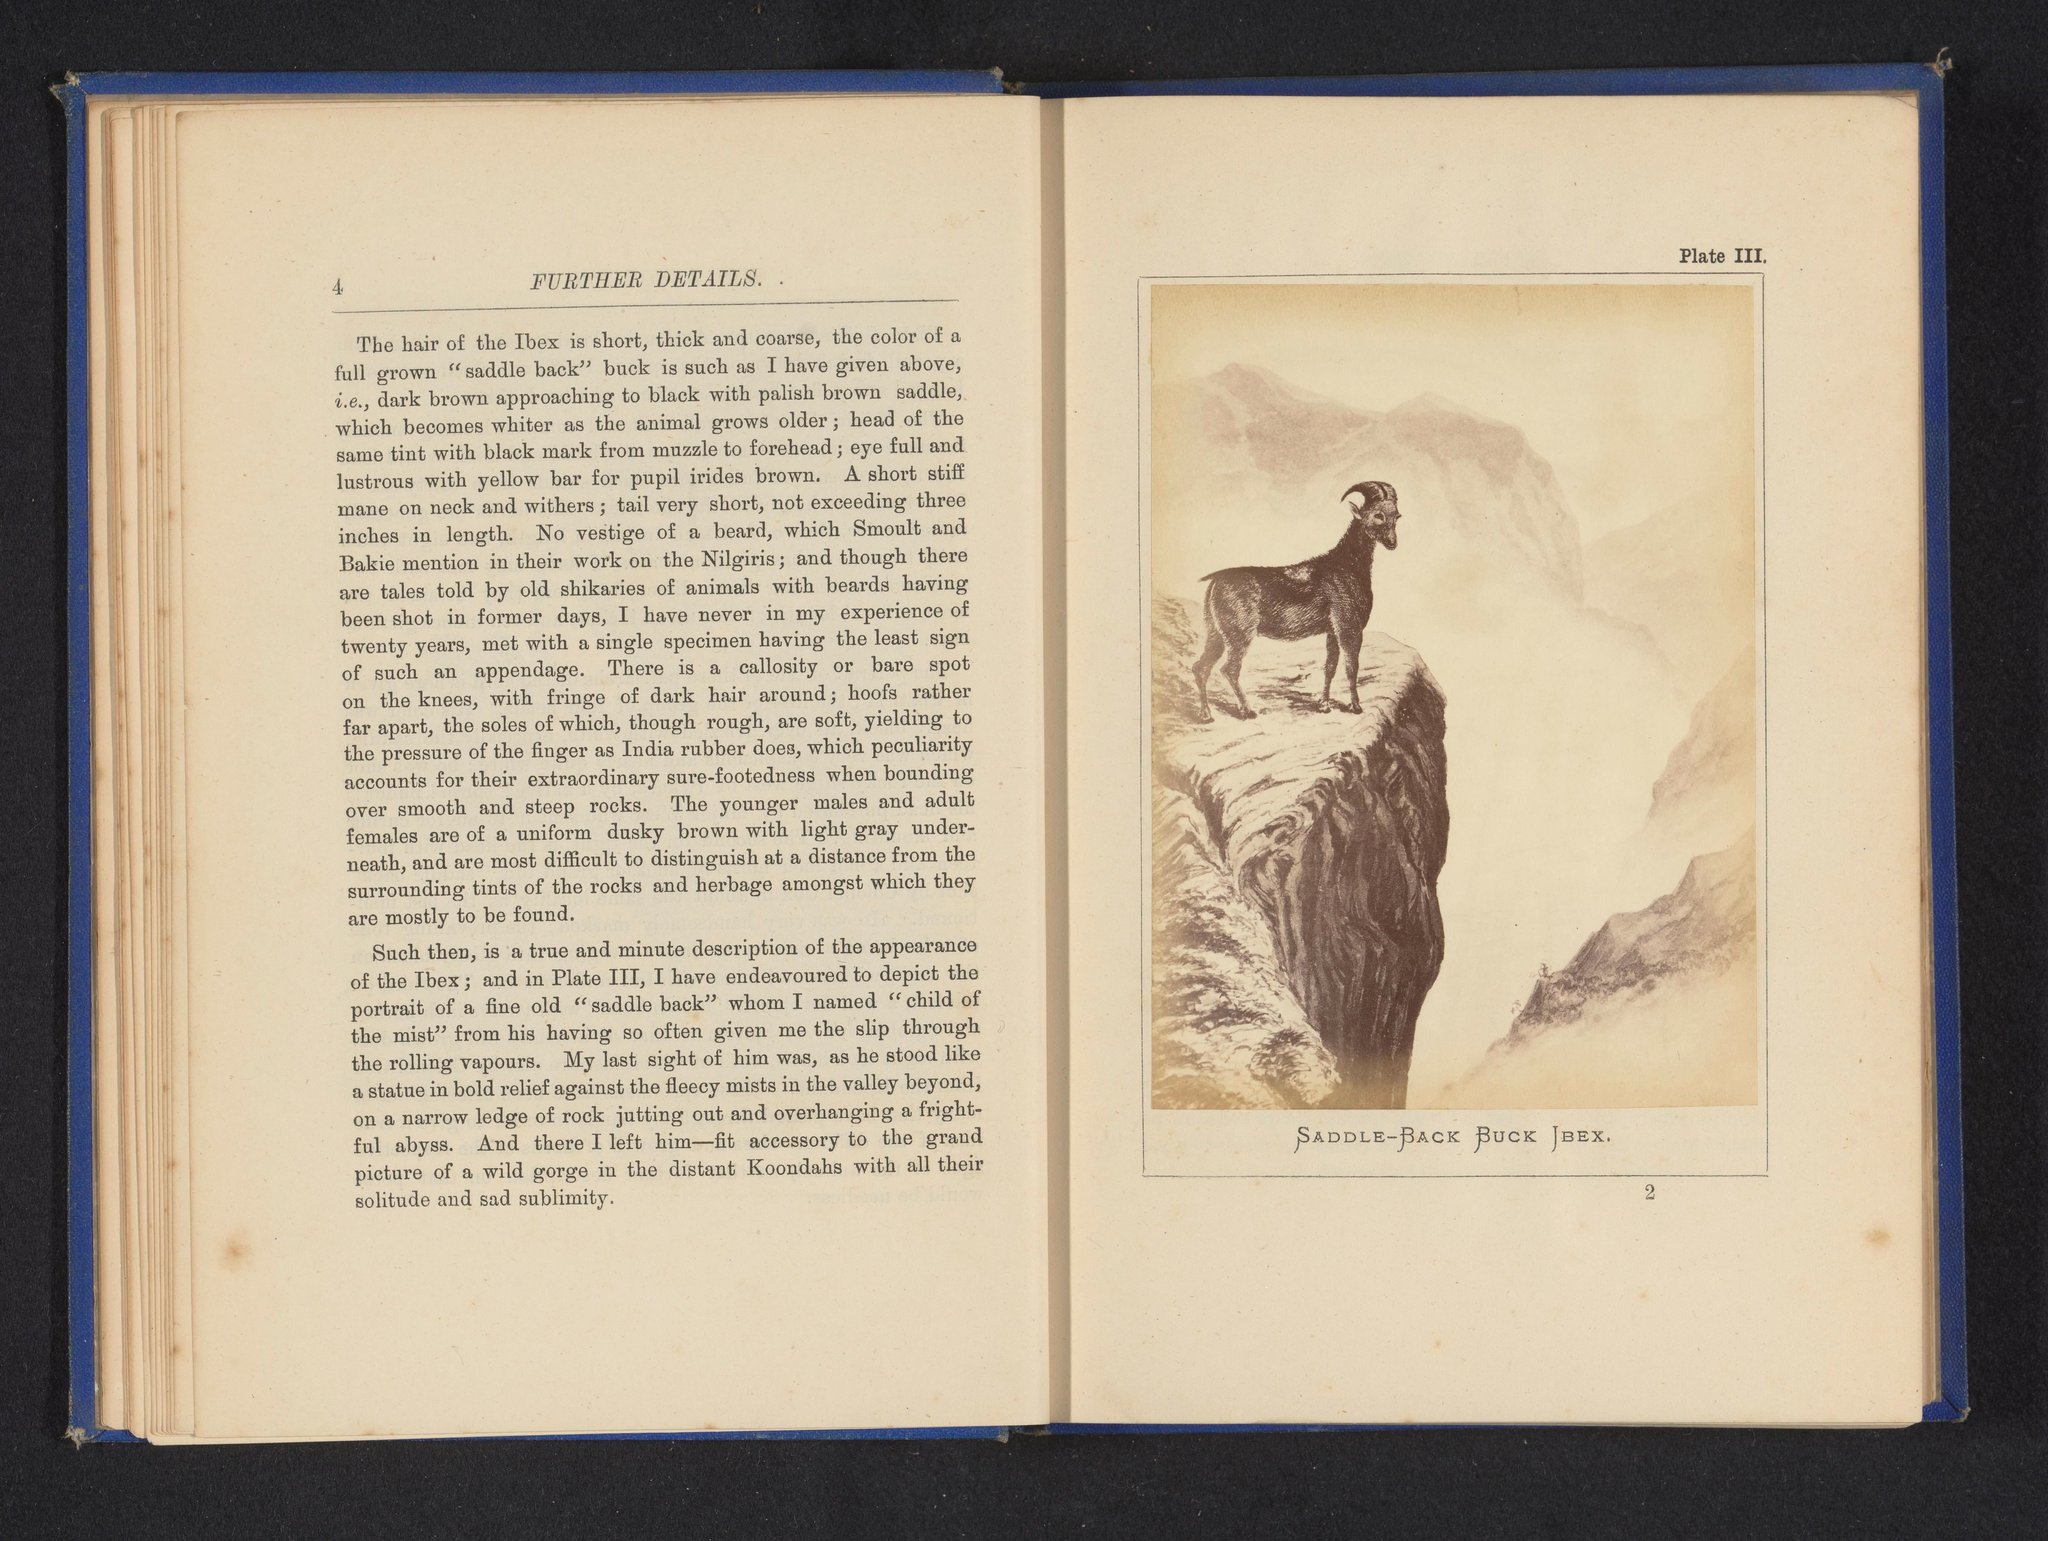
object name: reproduction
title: Fotoreproductie van een tekening van een Nilgirithargeit op een rots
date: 1870-1880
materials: photographic support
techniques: albumen print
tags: drawing, sketch, goat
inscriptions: number: ‘Plate III. 2’